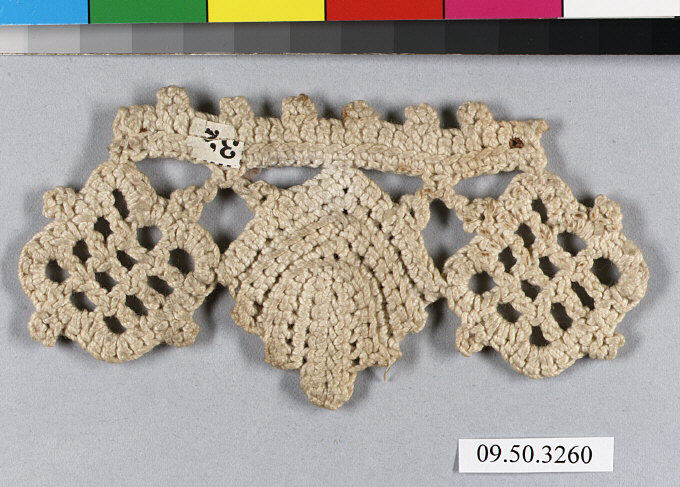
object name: sample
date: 1801-1900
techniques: crochet